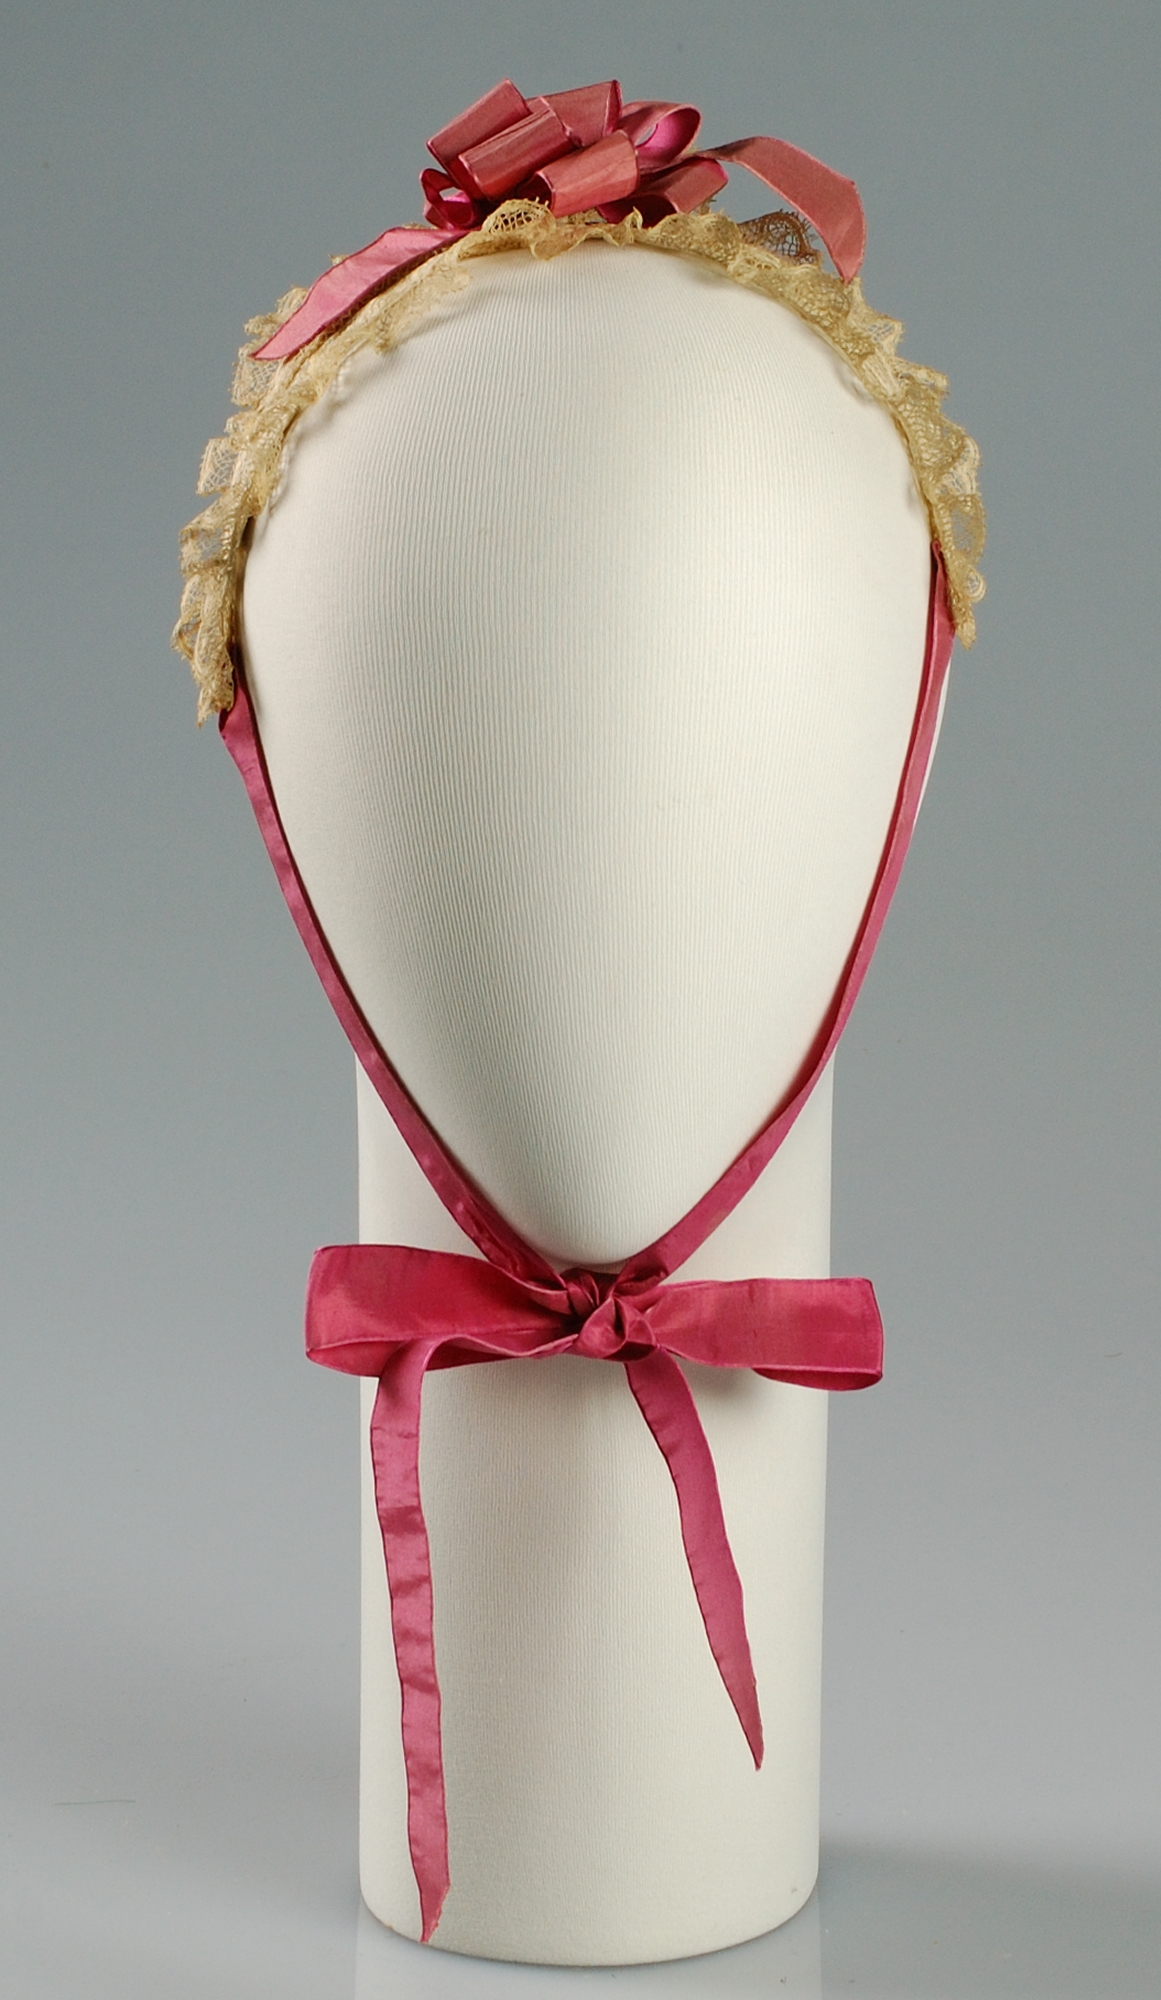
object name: morning cap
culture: american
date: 1870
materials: cotton, linen, silk